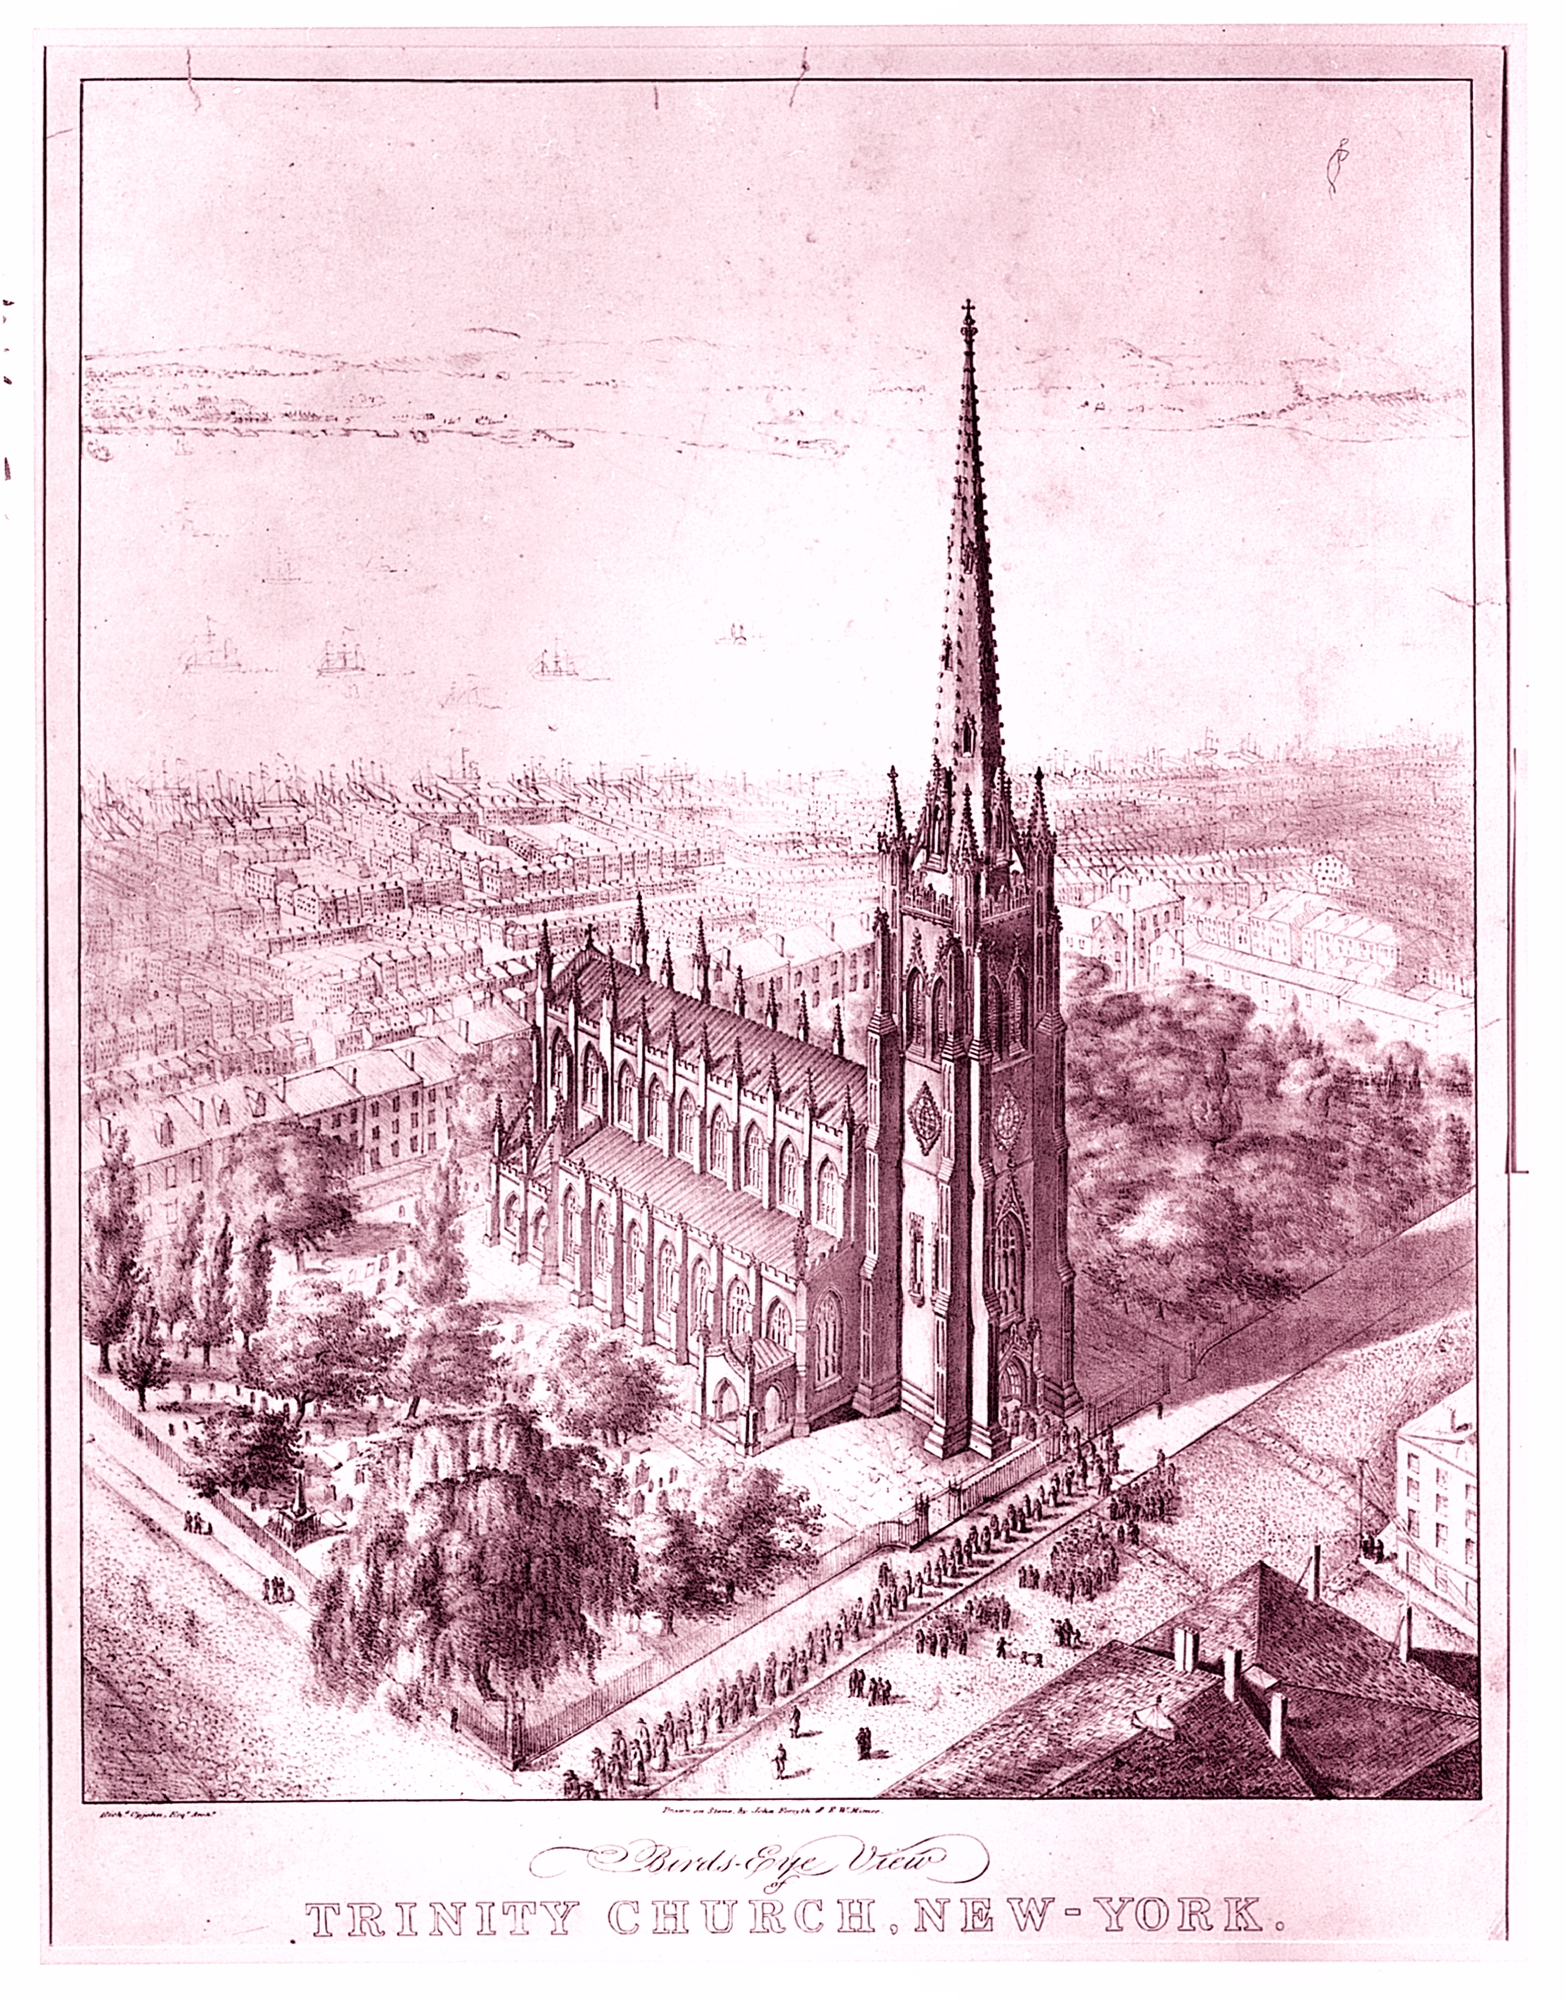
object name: print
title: Bird's Eye View of Trinity Church, New York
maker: john forsyth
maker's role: artist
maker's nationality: american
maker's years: 1845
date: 1847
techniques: lithograph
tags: churches,new york city